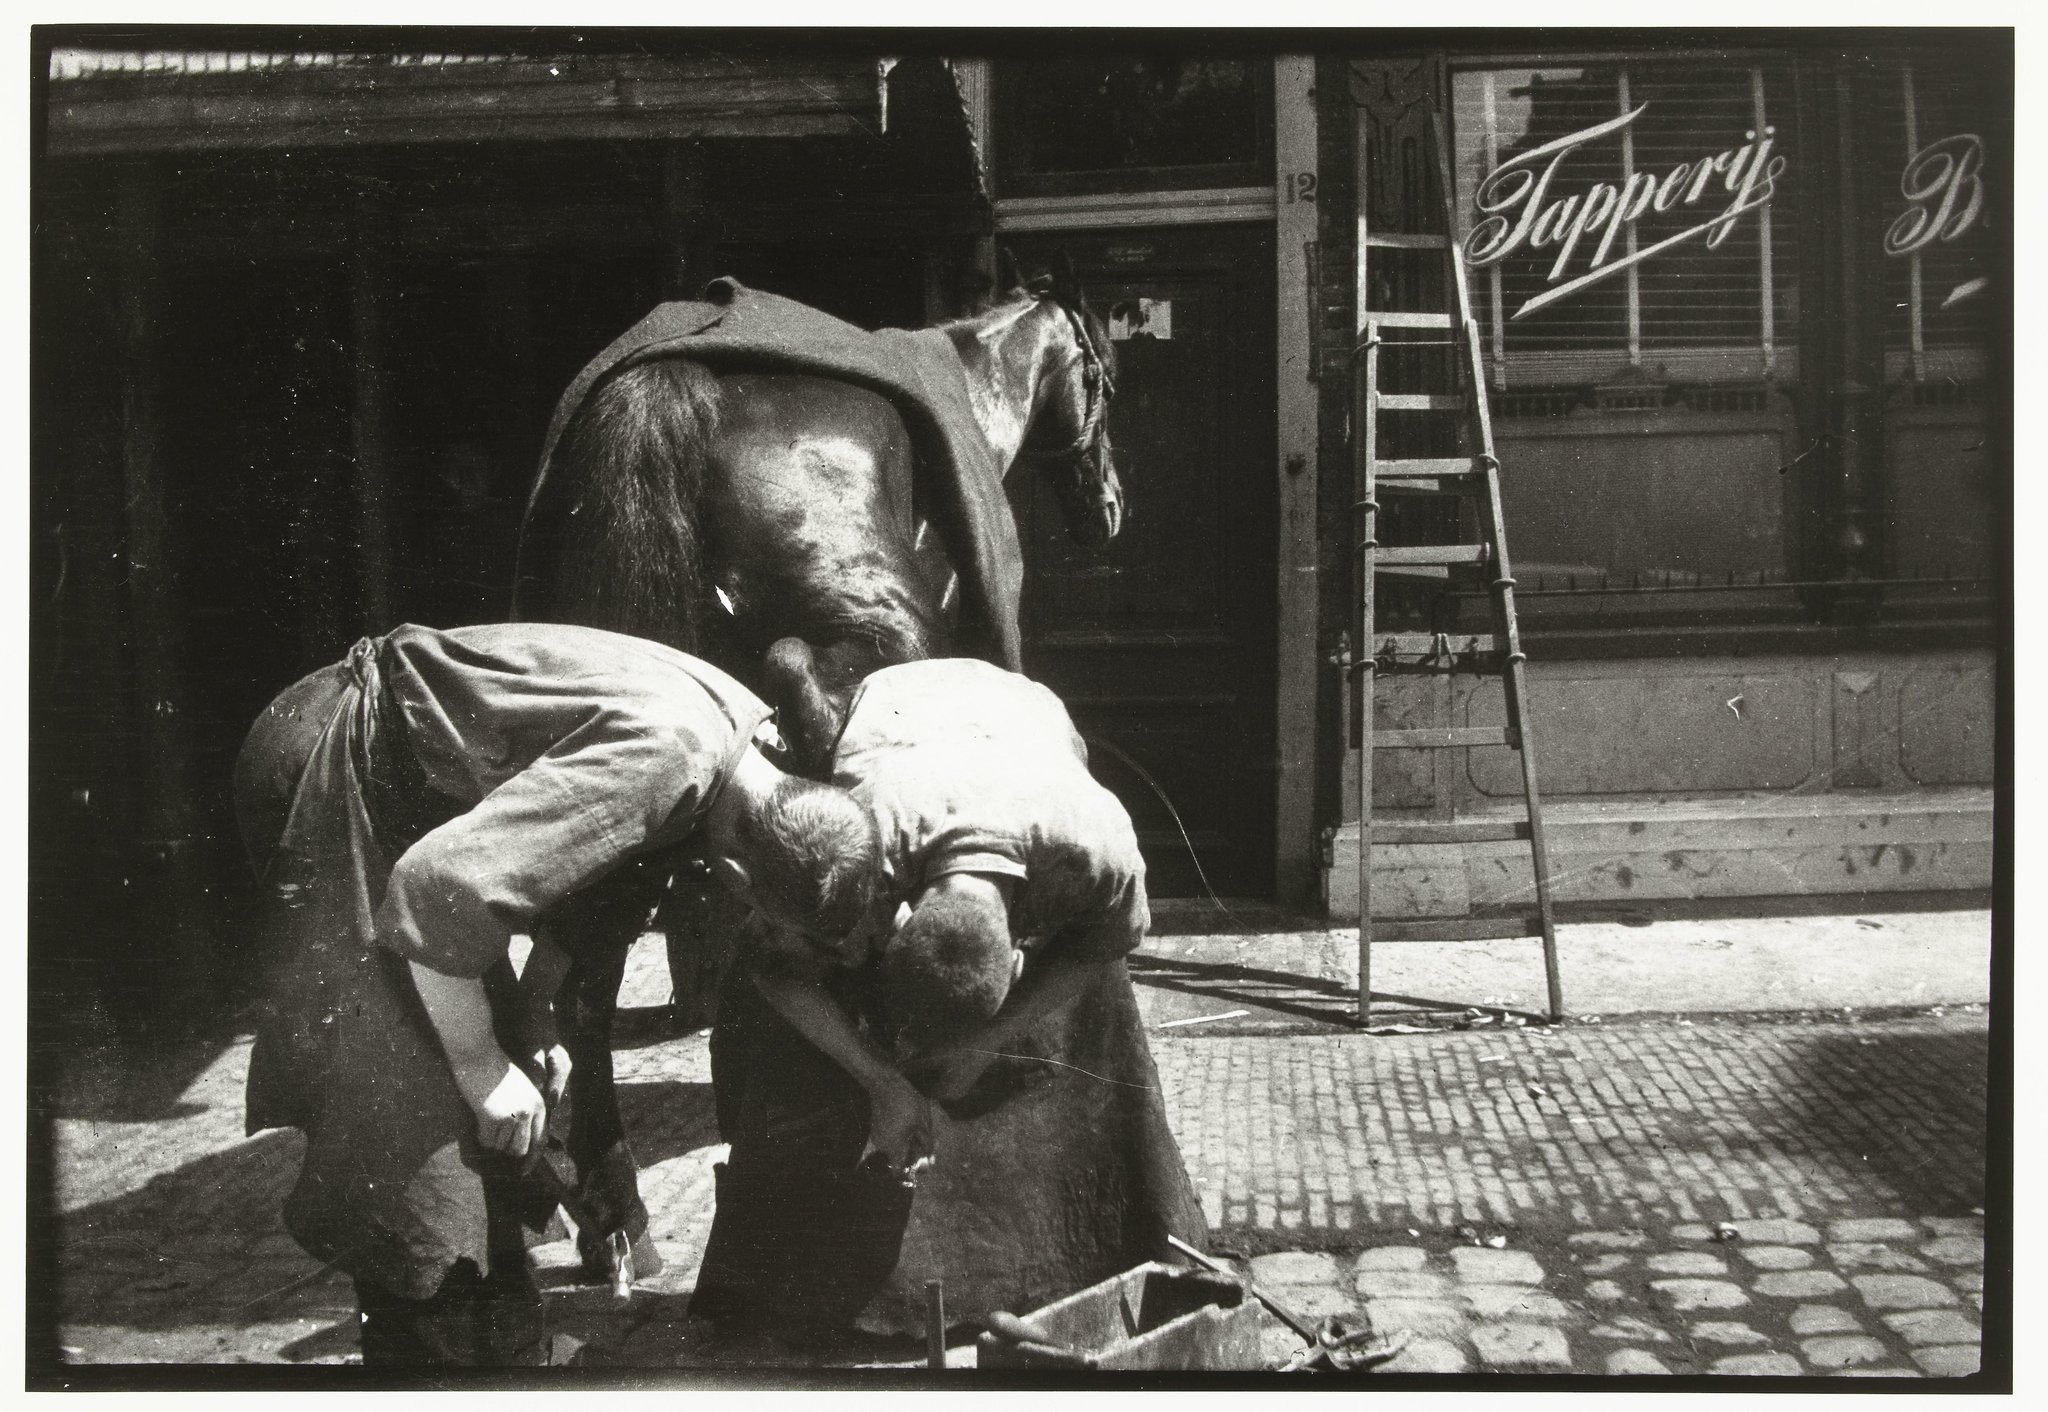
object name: photograph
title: Hoefsmid aan het werk met een paard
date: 1890-1900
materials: paper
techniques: gelatin silver print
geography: netherlands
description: Moderne afdruk van negatief BR 443 (collectie RKD).